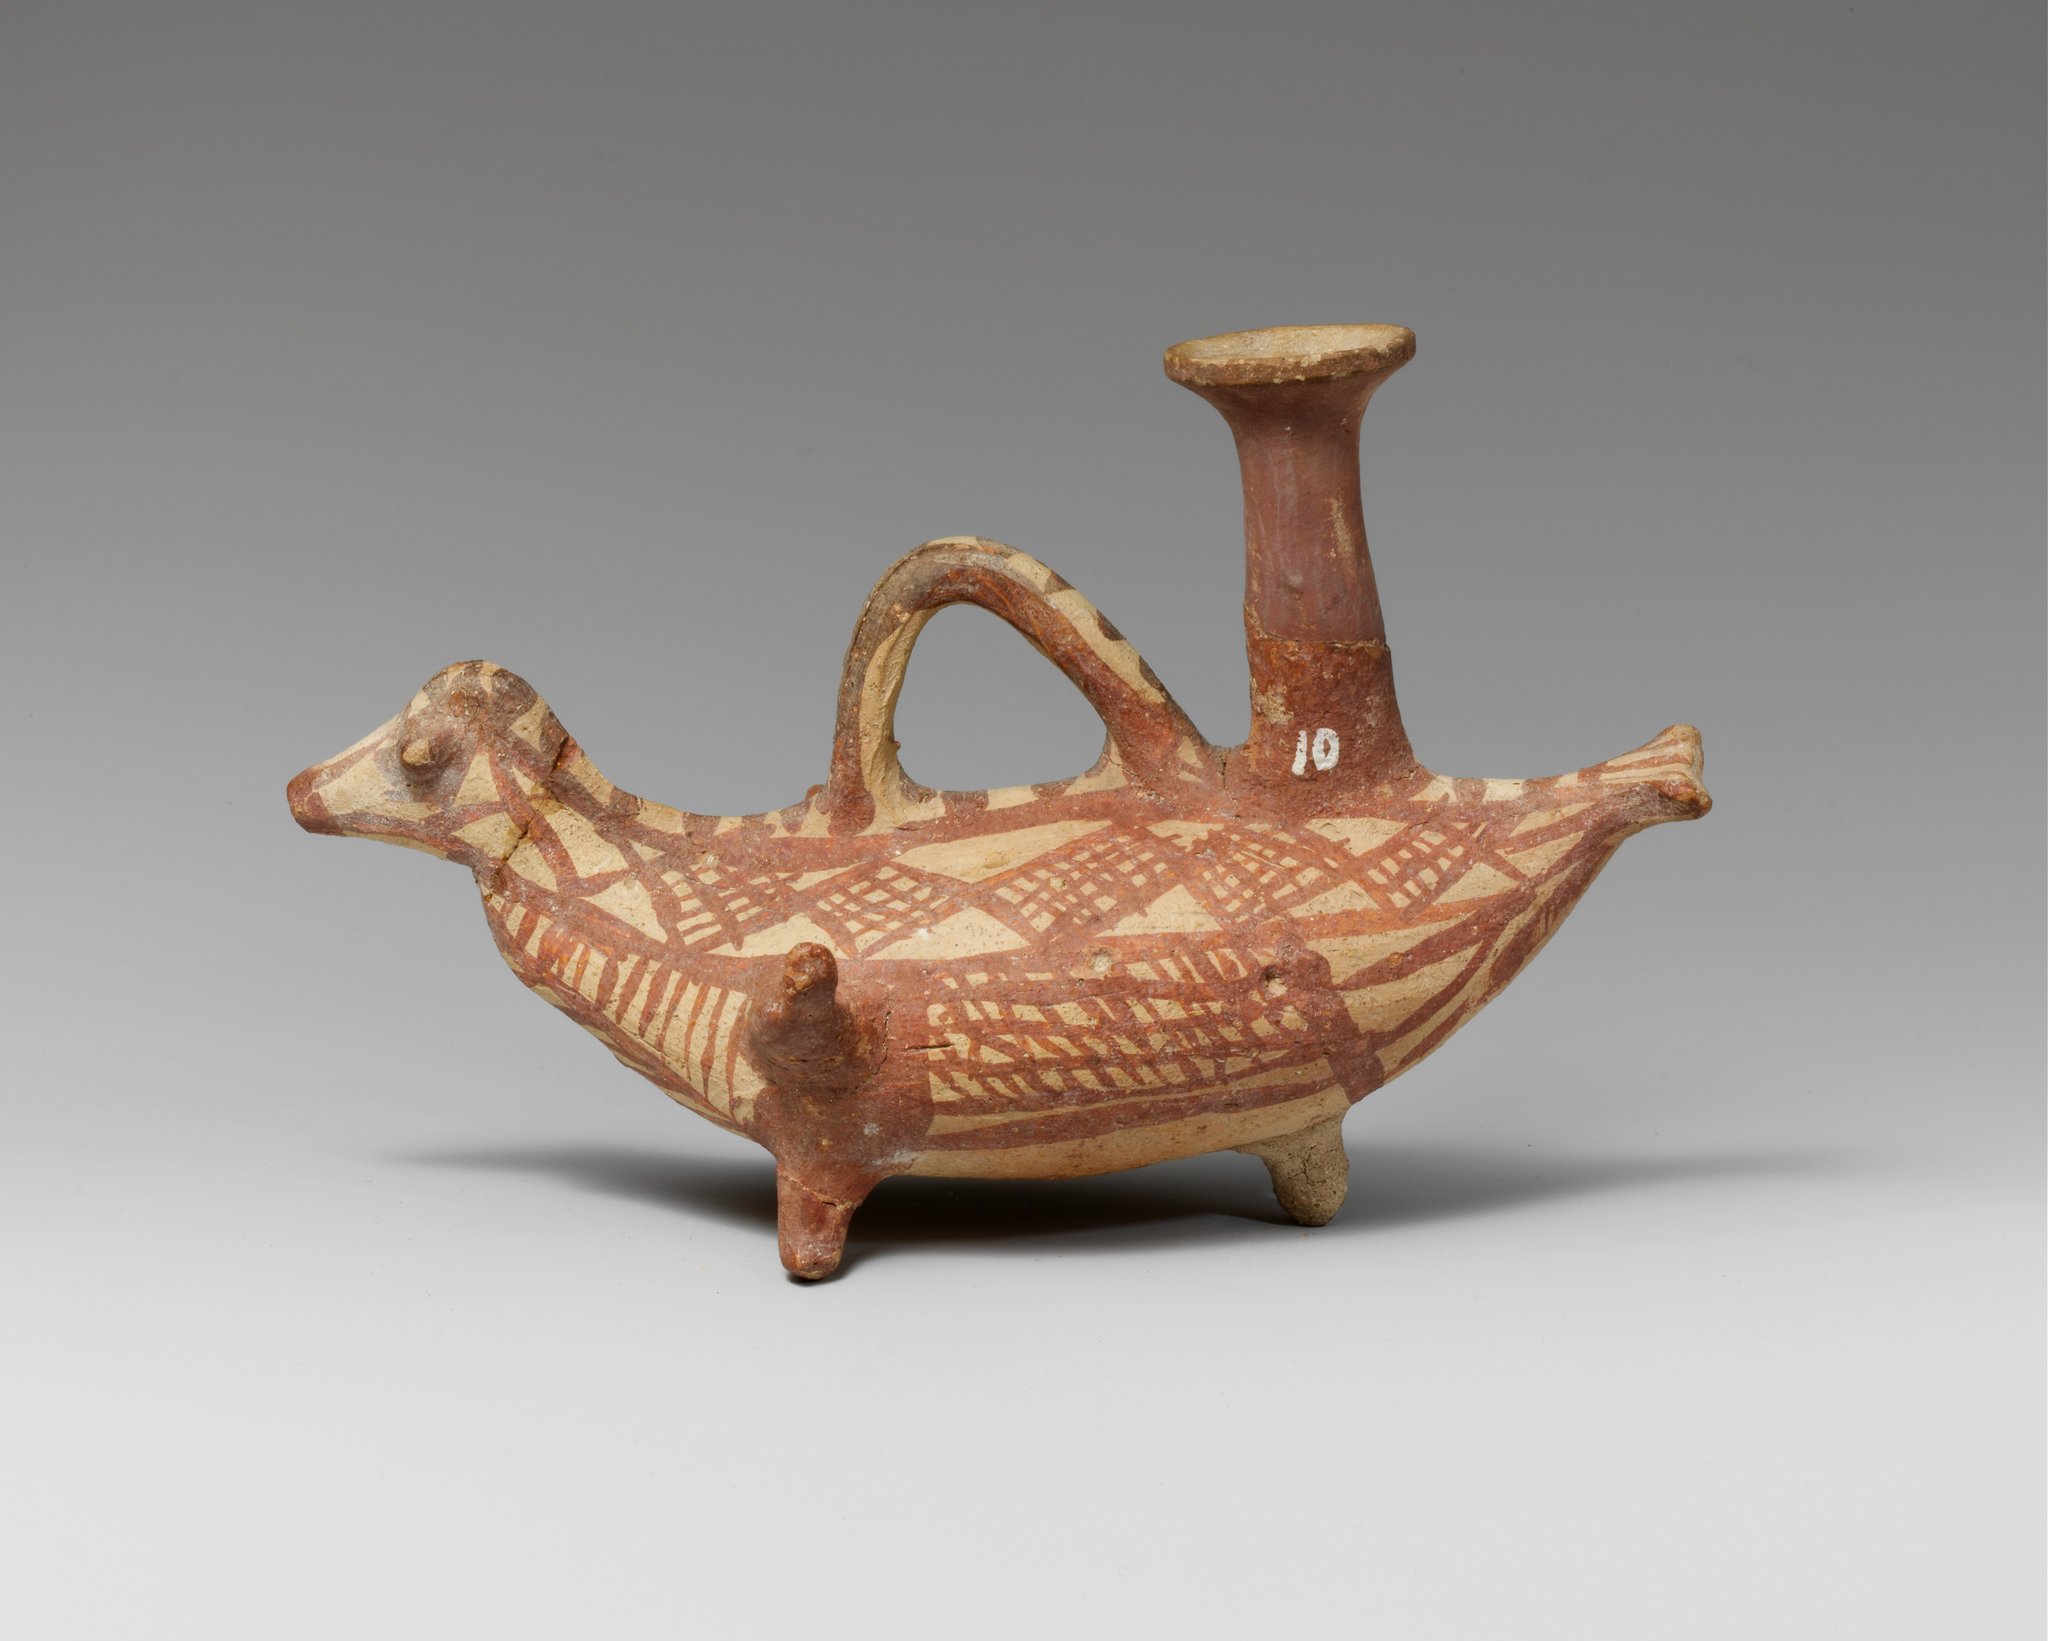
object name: askos in the form of a bird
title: Terracotta askos (flask with a spout and handle over the top) in the form of a bird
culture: cypriot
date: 1200-1050 BCE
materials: terracotta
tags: birds